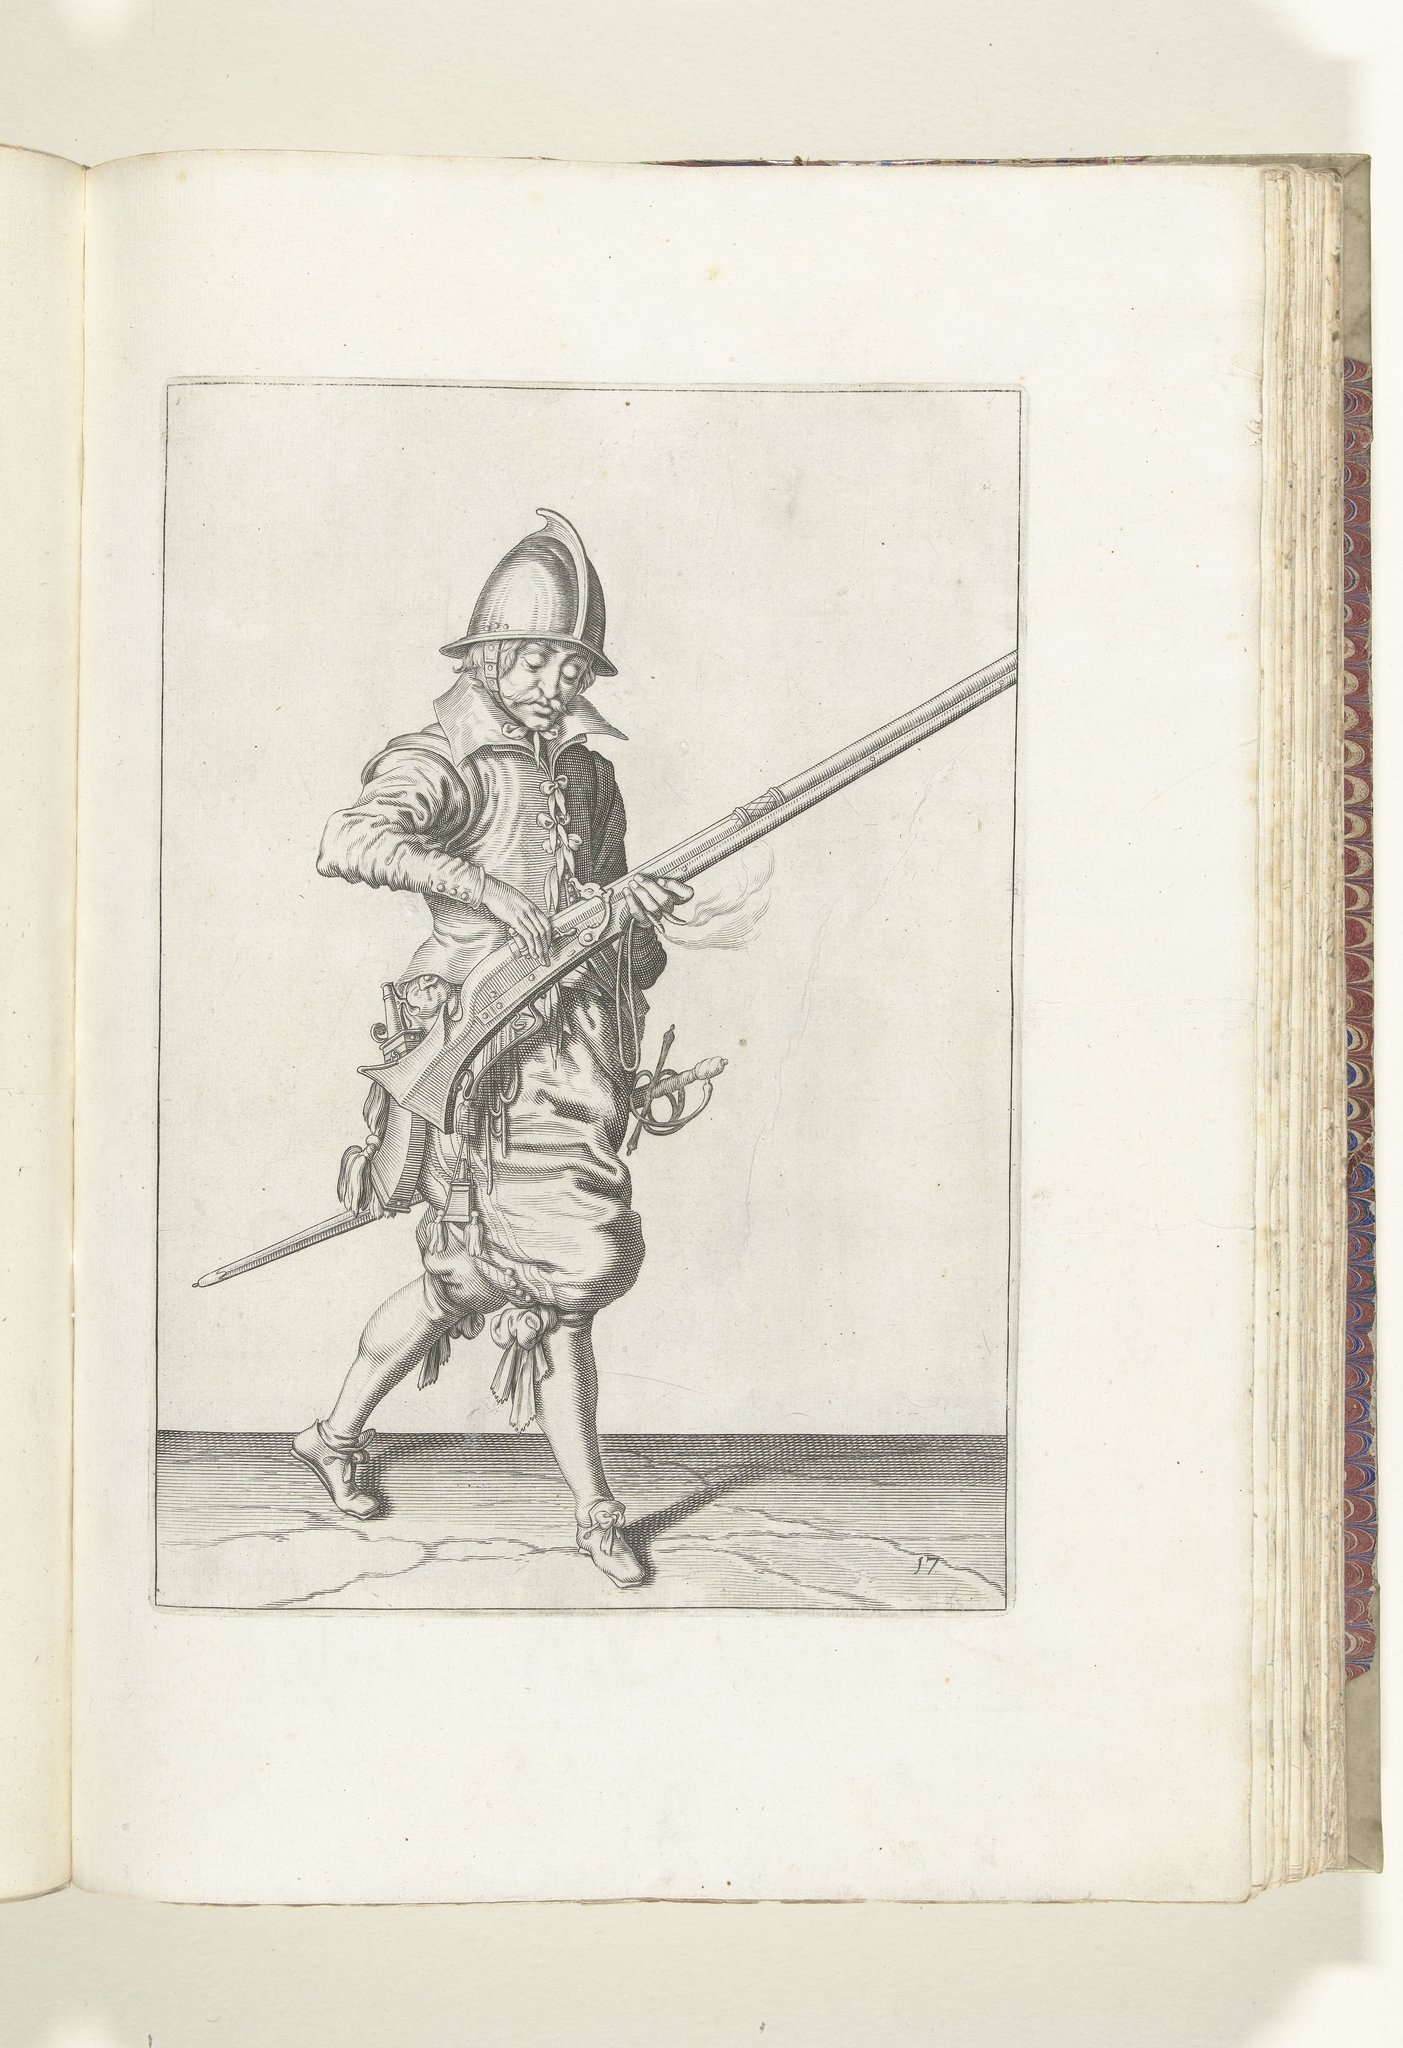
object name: print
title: Soldaat die de pan van zijn roer sluit (nr. 17), ca. 1600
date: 1597-1607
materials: paper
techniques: engraving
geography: amsterdam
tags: maurice (prince of orange), handling of weapons ~ military training, weapons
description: Een soldaat, ten voeten uit, naar rechts, die met zijn rechterhand de pan (het kruitreservoir) van zijn roer (een bepaald type vuurwapen) sluit (nr. 17), ca. 1600. In zijn linkerhand behalve het roer ook een brandende lont. Plaat 17 in de instructies voor het hanteren van de roer. Onderdeel van de illustraties in: J. de Gheyn, Wapenhandelinghe van Roers Musquetten ende spiessen, Amsterdam, 1608. Krijgswezen rond 1600.